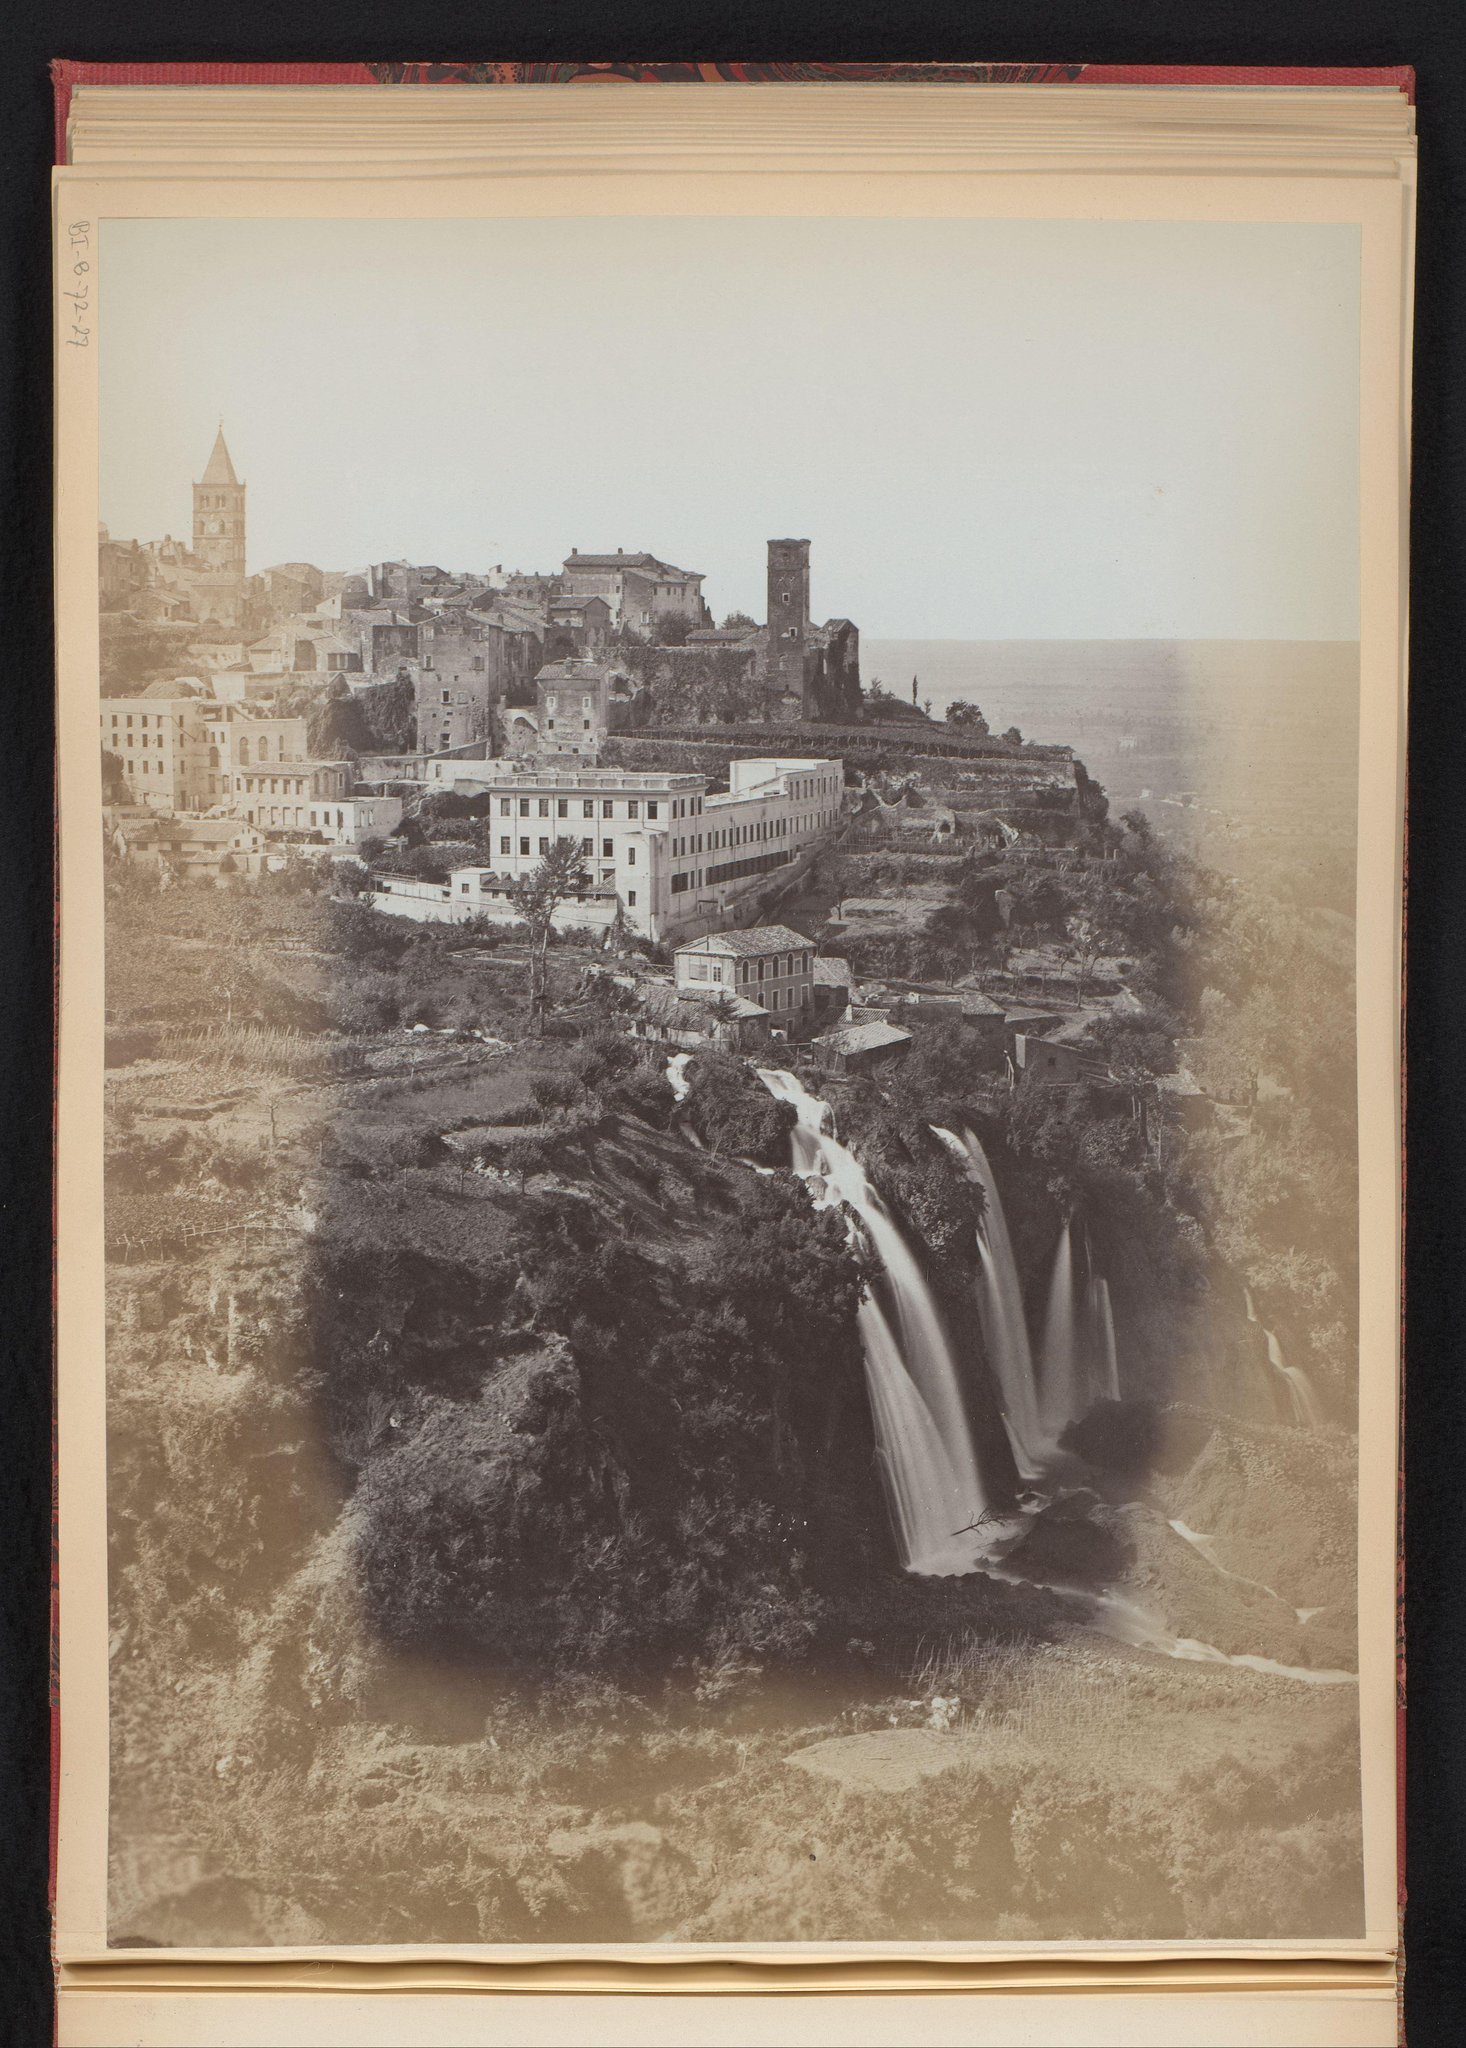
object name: album leaf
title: Watervallen van Tivoli, Italië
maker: Anonymous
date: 1870-1890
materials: paper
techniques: albumen print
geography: tivoli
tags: city-view in general; 'veduta', waterfall, landscapes with waters, waterscapes, seascapes (in the temperate zone), tivoli